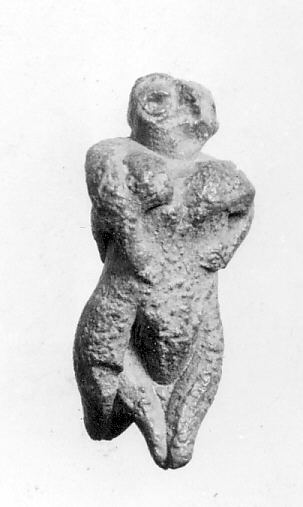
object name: figurine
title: Two Figures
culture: central asian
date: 1101-1133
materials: earthenware